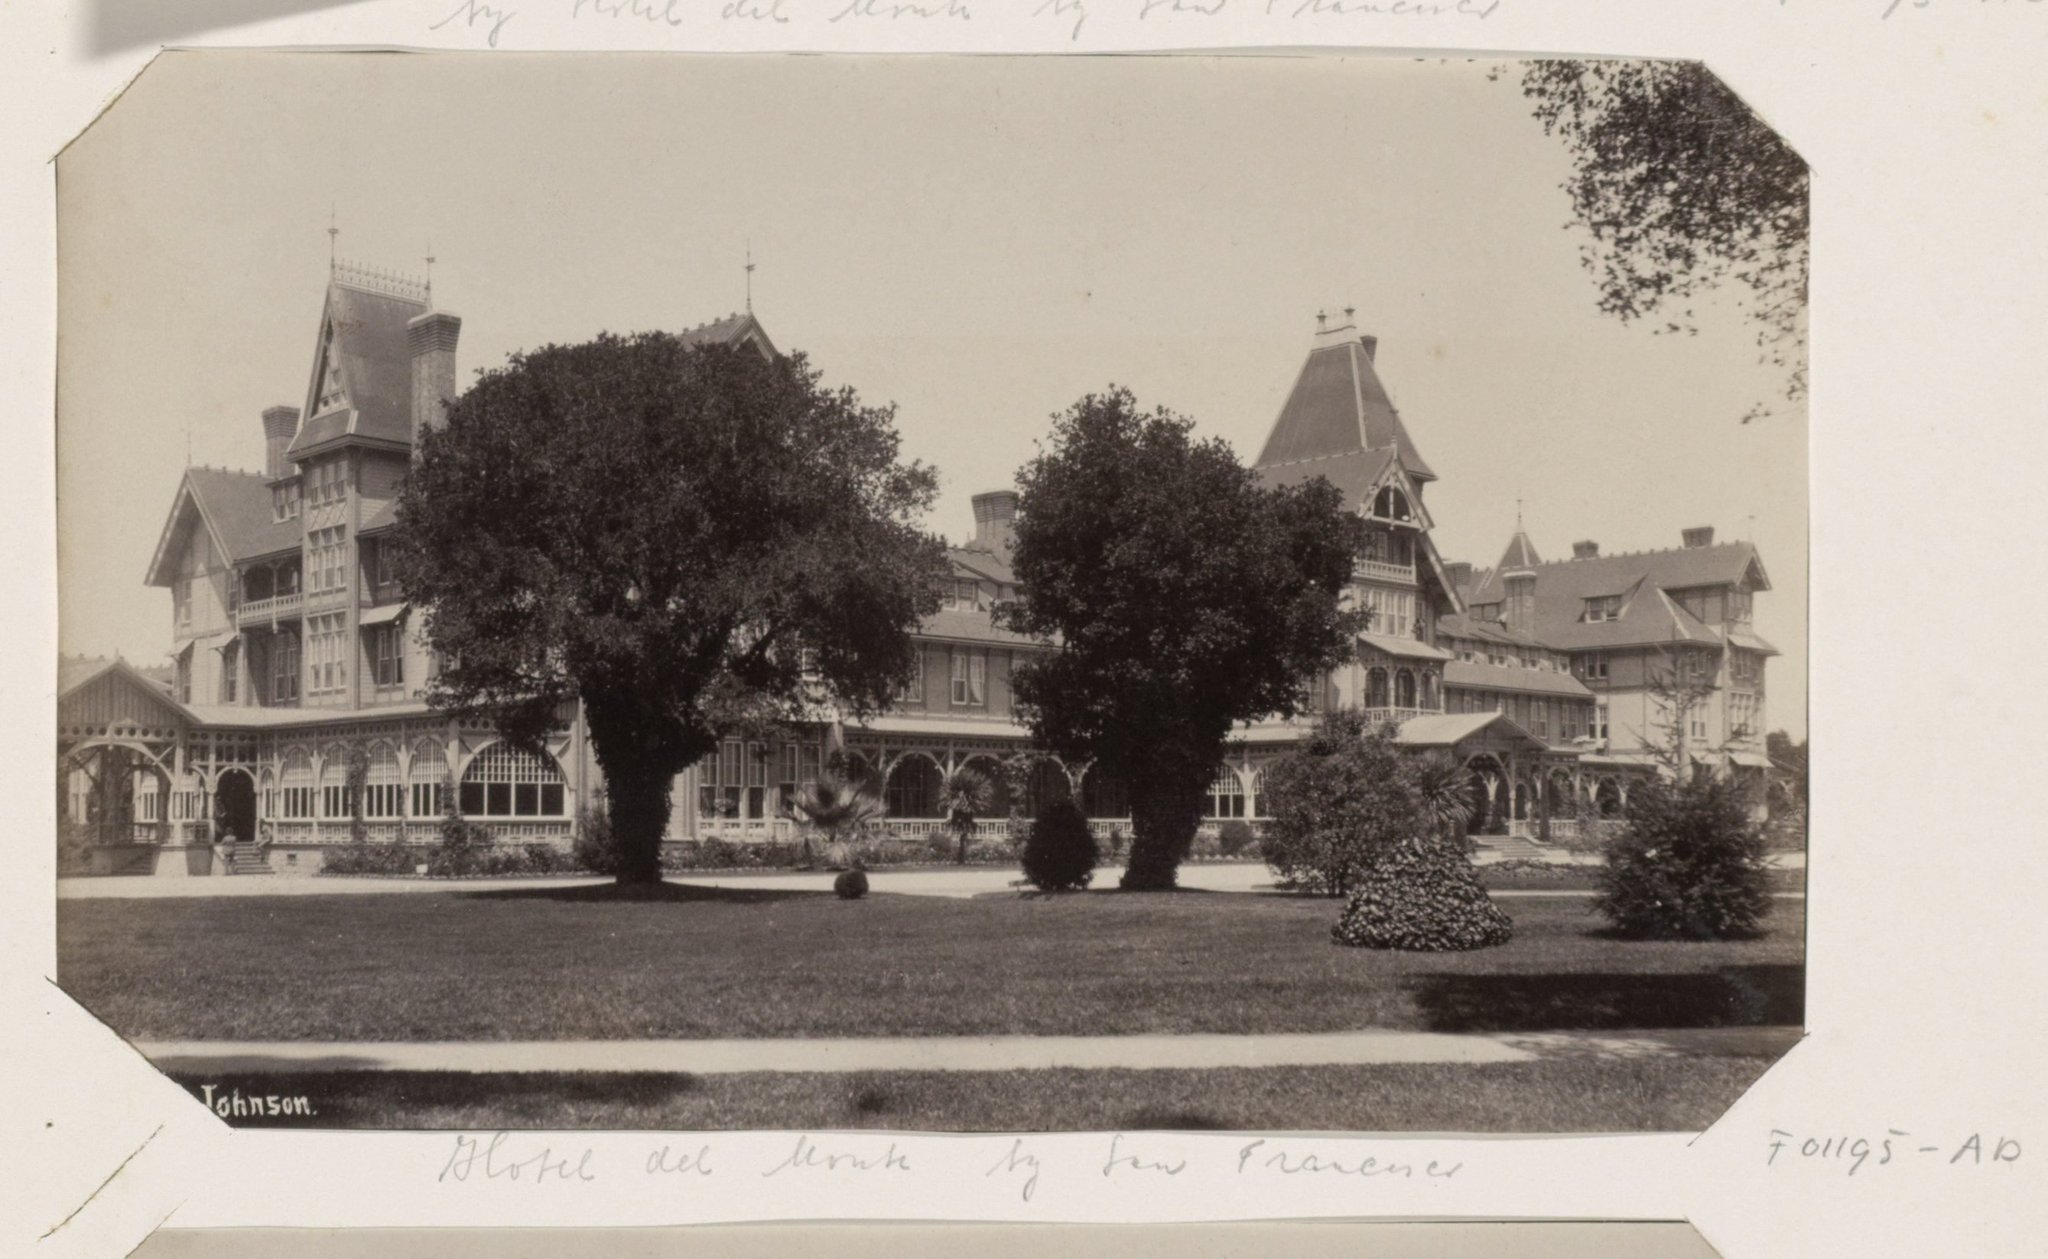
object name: photograph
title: Exterieur en tuin van Hotel del Monte in San Francisco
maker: johnson (fotograaf)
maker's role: fotograaf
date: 1880-1900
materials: cardboard, paper, photographic support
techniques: albumen print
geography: san francisco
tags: hotel del monte (san francisco), san francisco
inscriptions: negative number: ‘9’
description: Onderdeel van Fotoalbum van een reis door de Verenigde Staten, Honolulu, Nederlands-Indië, Aden, Zanzibar en Zuidelijk Afrika.